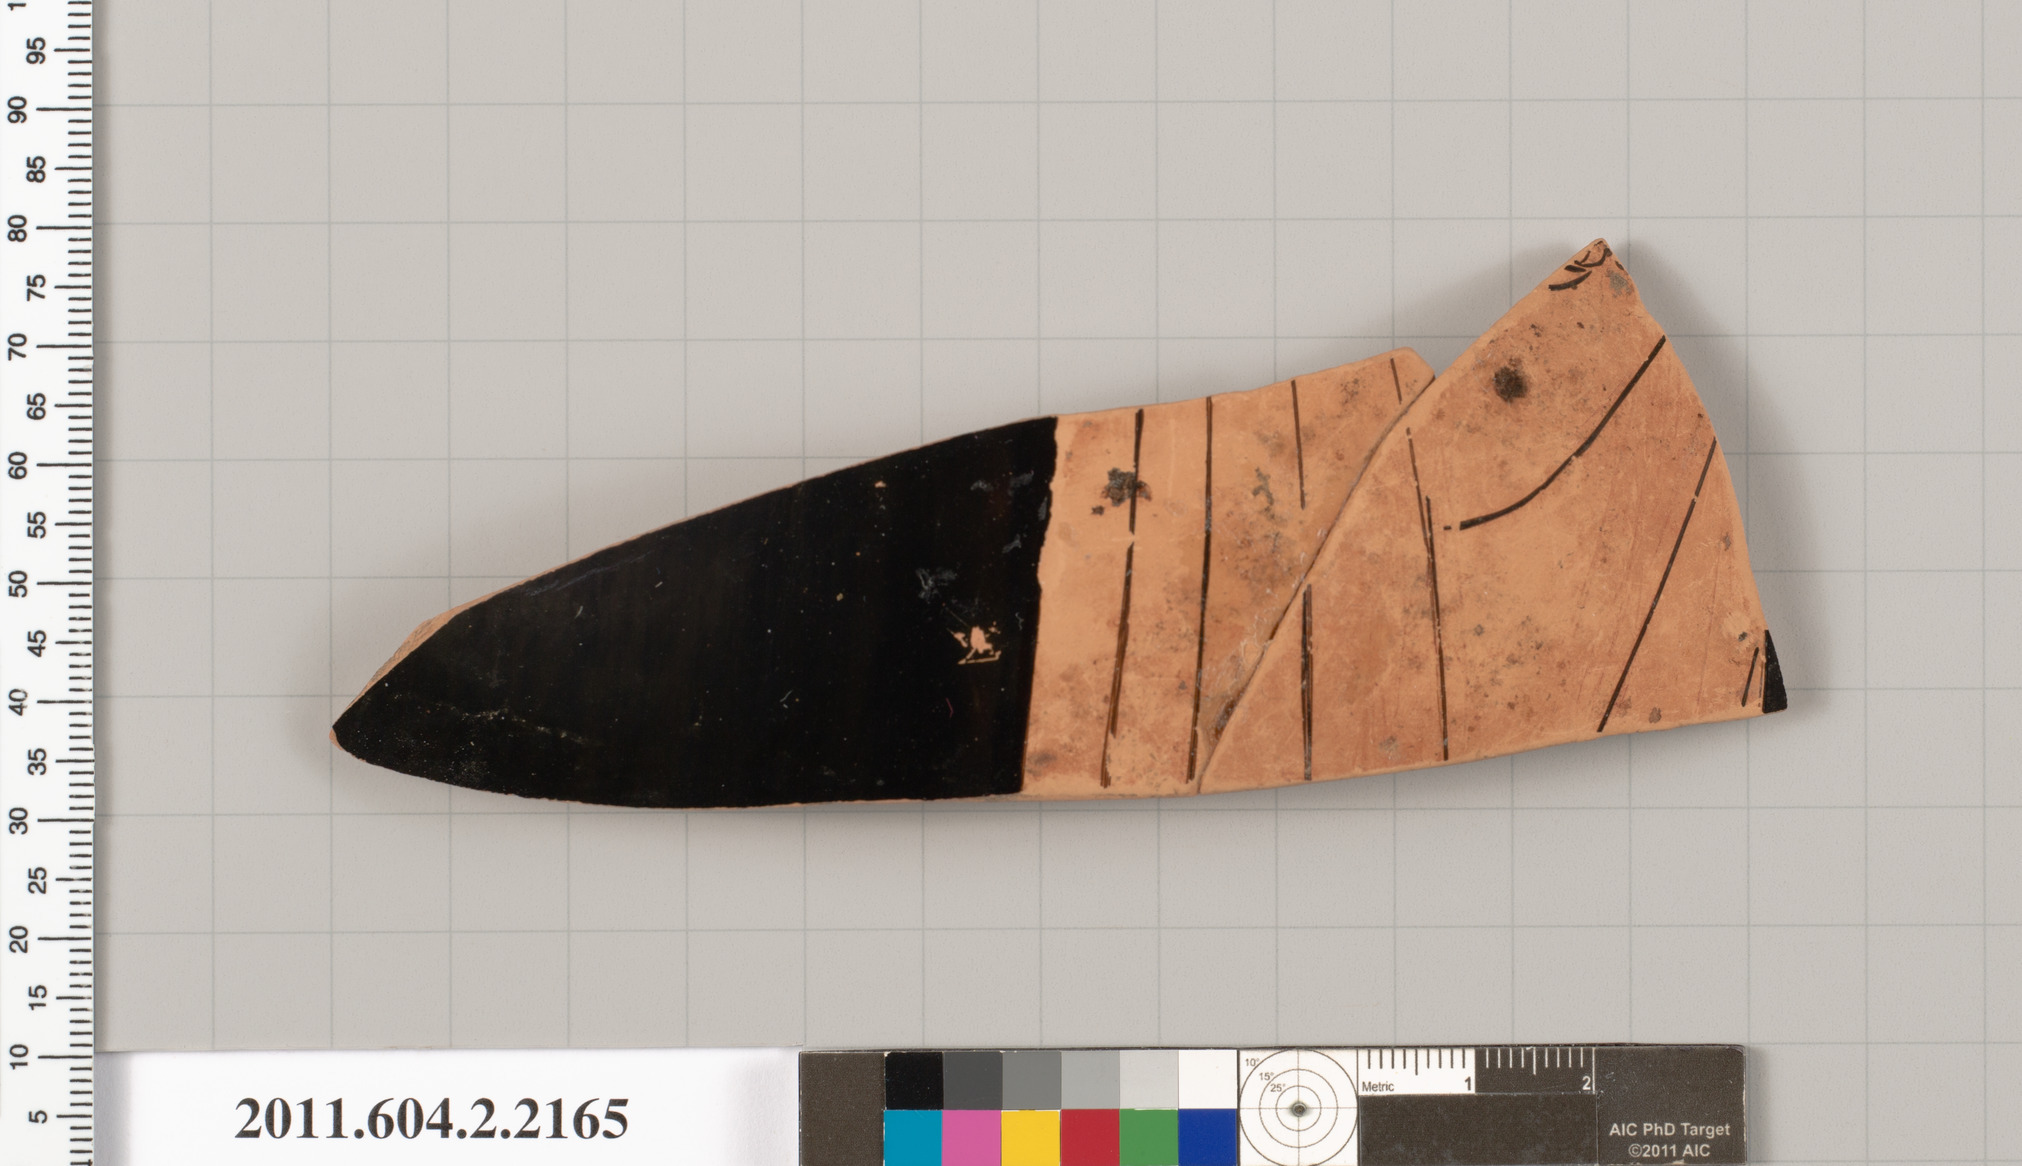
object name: pot fragment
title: Terracotta fragment of a pot; unglazed on the inside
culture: greek, attic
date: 475-451 BCE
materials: terracotta